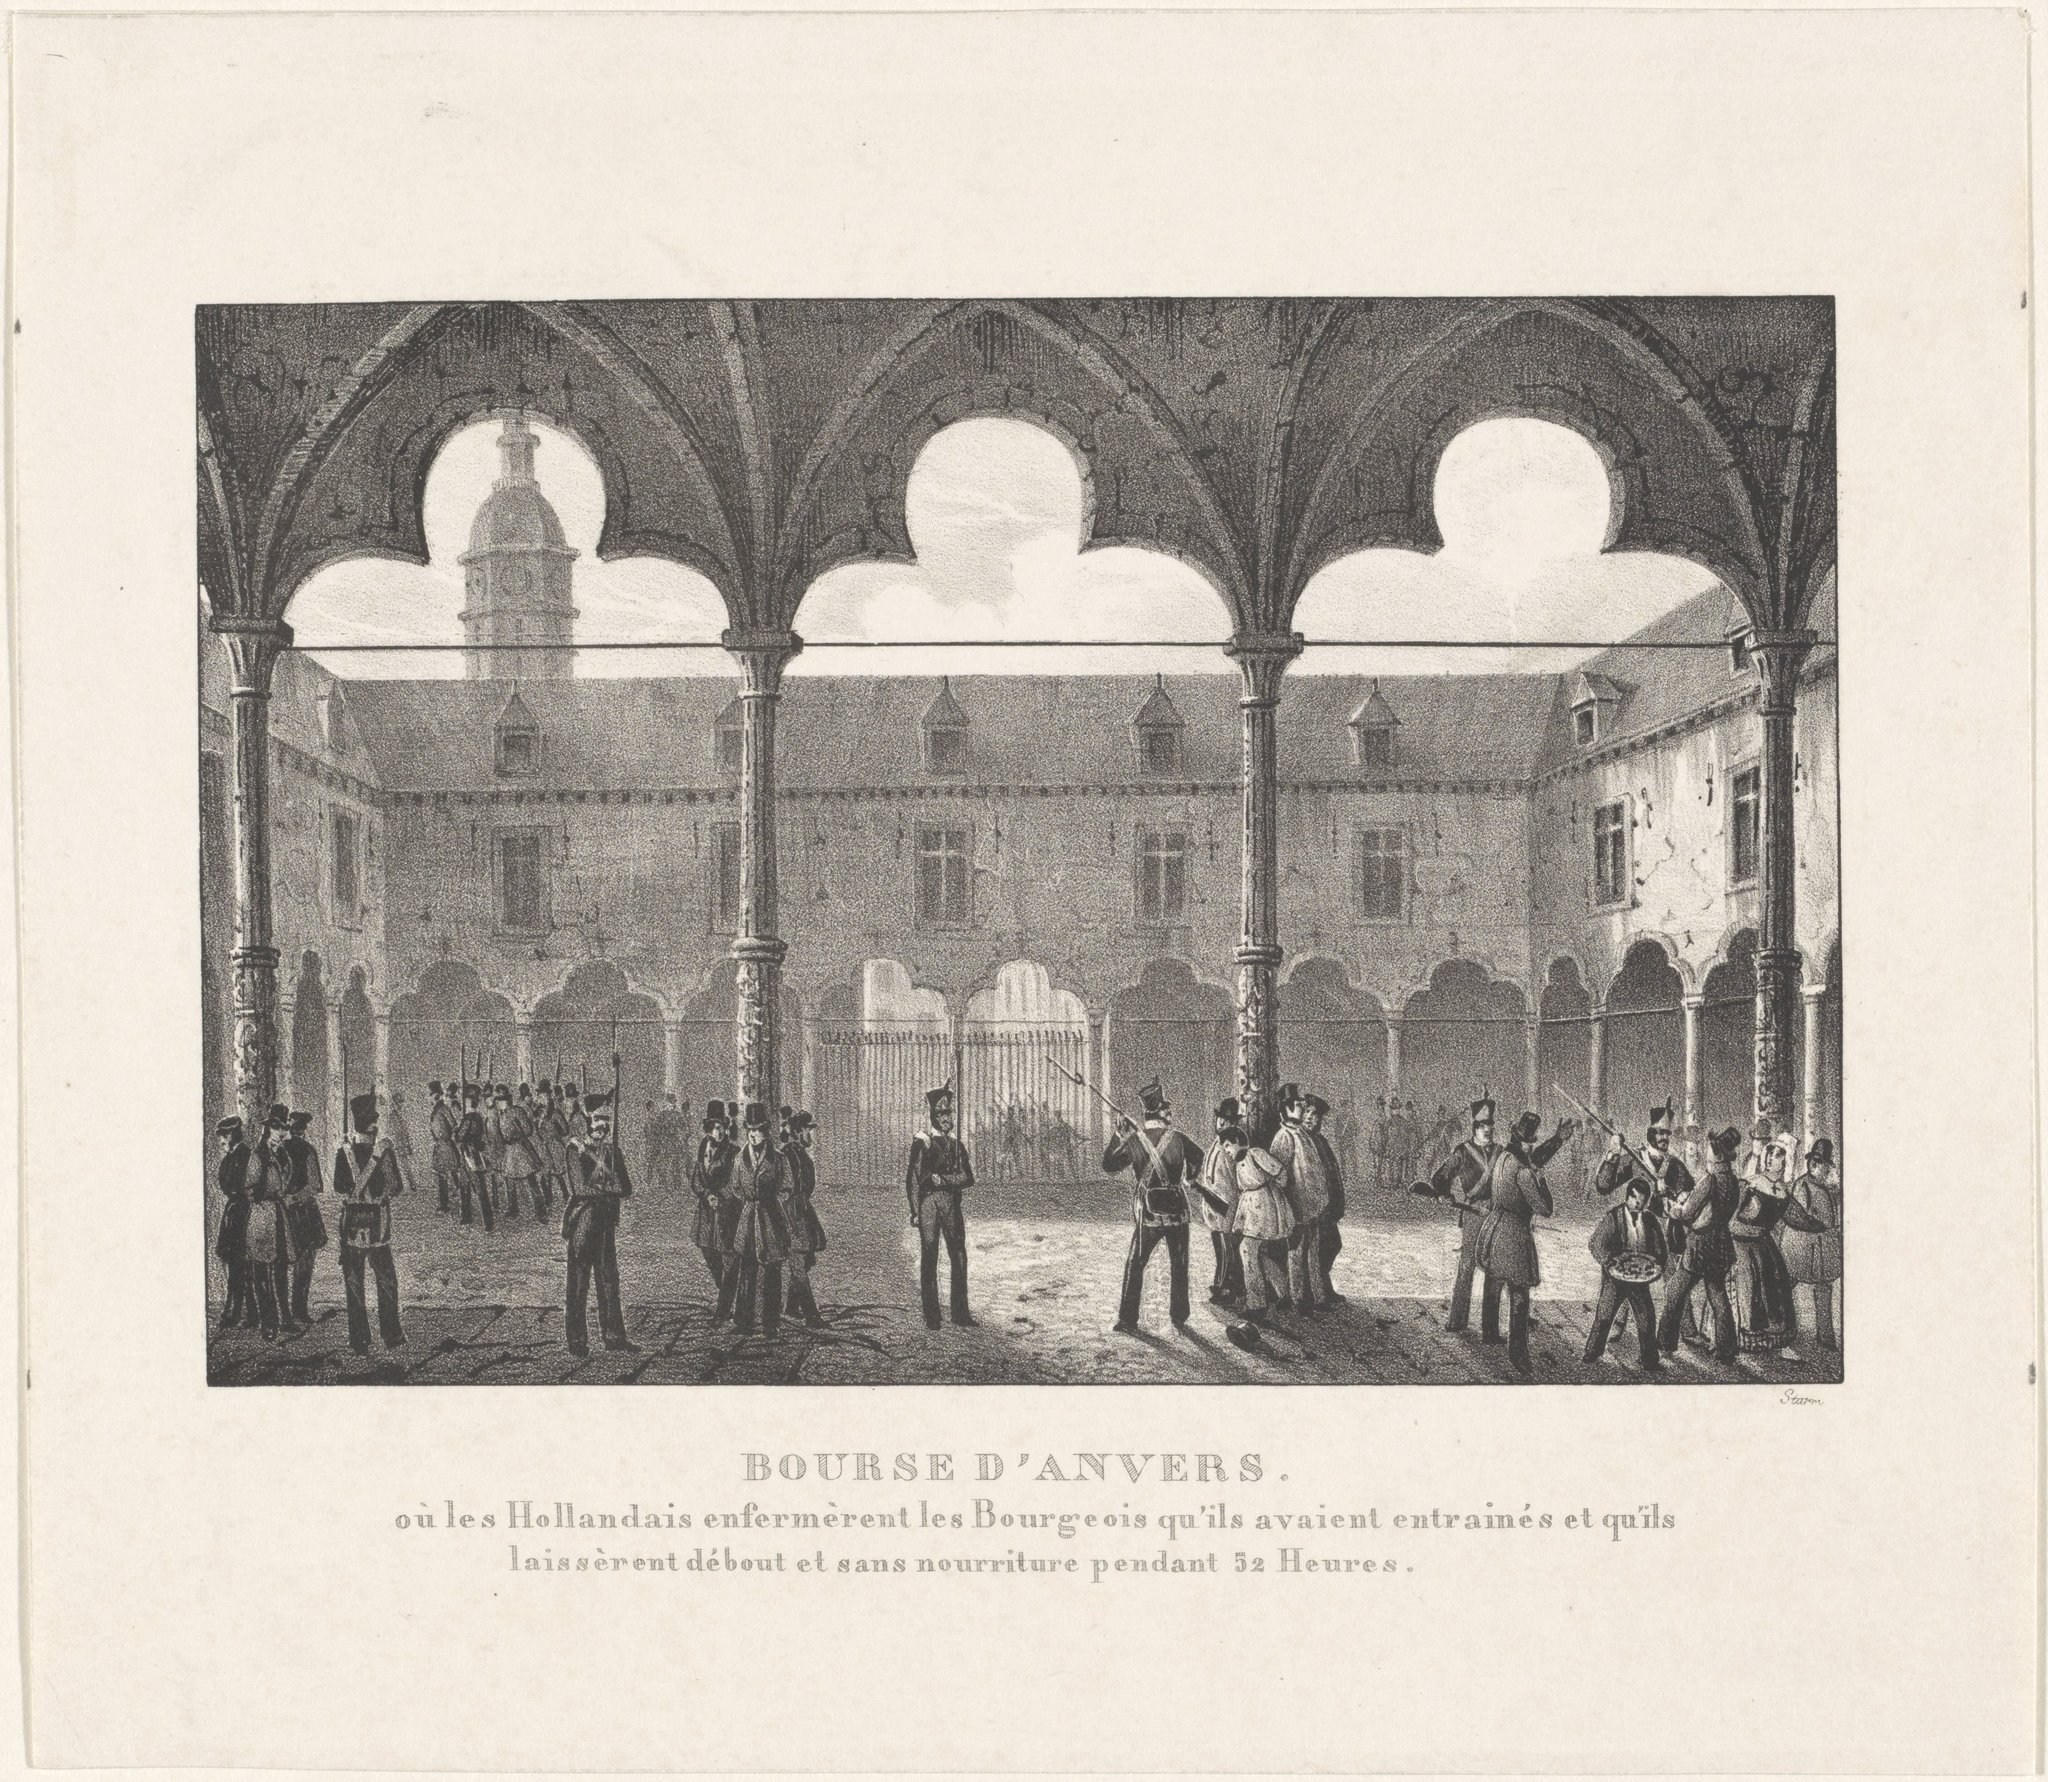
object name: print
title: Gevangenen in de Beurs van Antwerpen, 1830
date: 1830-1831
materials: paper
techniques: lithograph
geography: brussels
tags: prison, jail, prisoner of war camp, antwerp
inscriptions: collector's mark: Lugt 2228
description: Nederlandse troepen sluiten gevangen genomen opstandige burgers op in de Beurs van Antwerpen, gedurende 52 uren zonder voedsel, 1830. Onderdeel van een groep van prenten uit verschillende andere series verwant aan de platen in het recueil over de gebeurtenissen tijdens de Belgische Revolutie in Brussel, Antwerpen en andere steden in de periode 25 augustus 1830 tot 27 maart 1831.